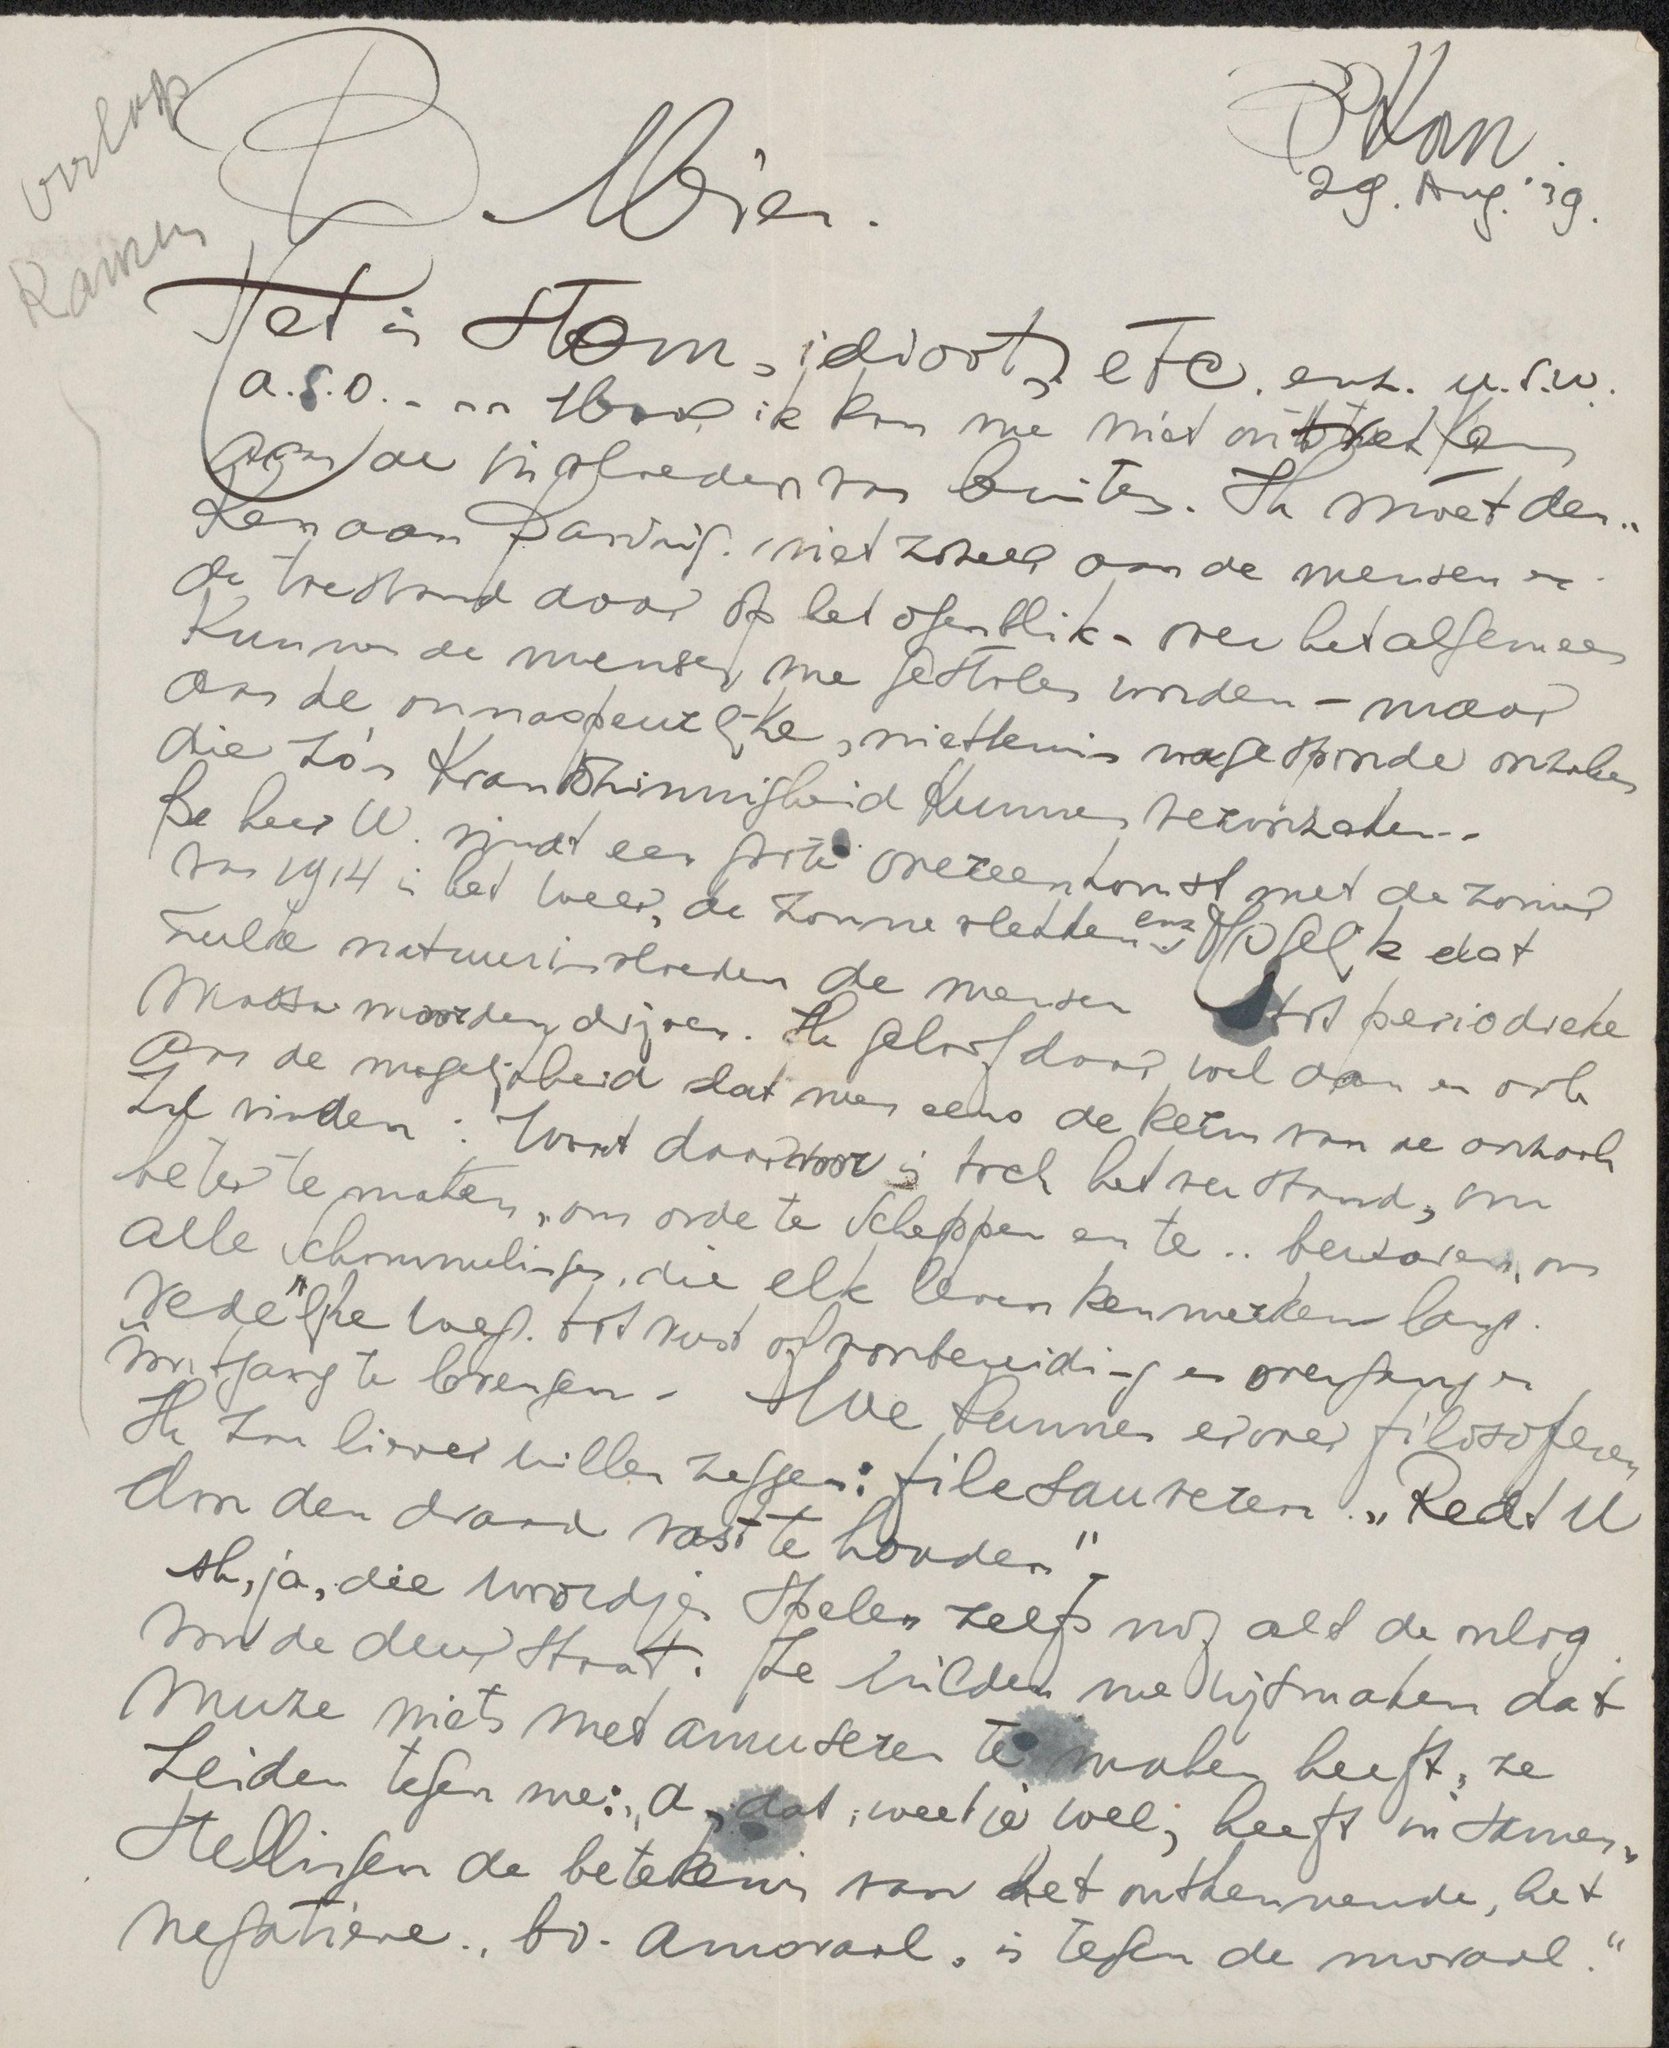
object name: letter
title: Brief aan Mien Cambier van Nooten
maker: dick ket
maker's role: draughtsman, print maker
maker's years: 1902-1940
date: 1939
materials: ink, paper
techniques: pen, writing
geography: bennekom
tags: amsterdam, arnhem, mien cambier van nooten